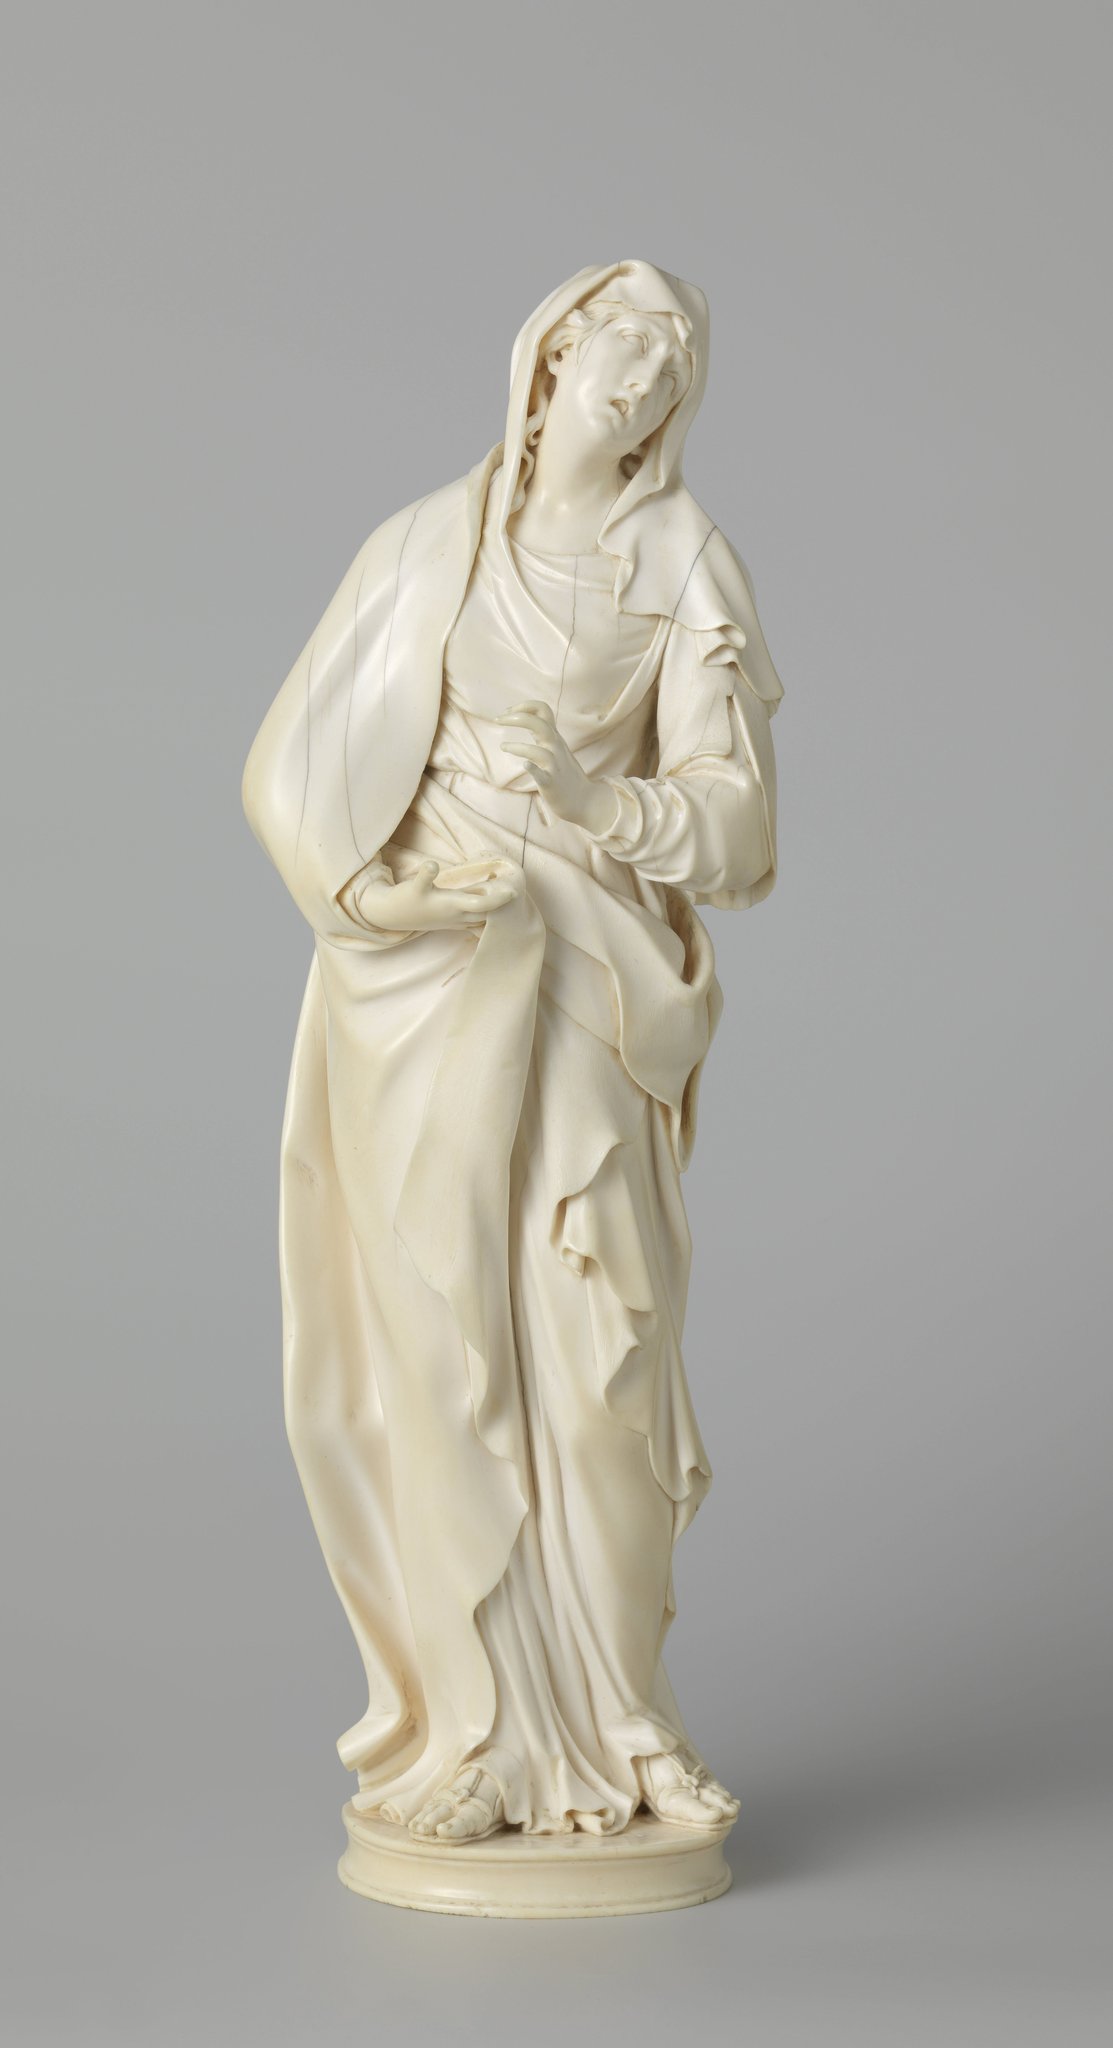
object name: figure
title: The Virgin and St John the Evangelist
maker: mattheus van beveren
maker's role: ivory carver, sculptor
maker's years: 1630-1690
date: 1670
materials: ivory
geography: brussels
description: The figures of the Virgin and the Apostle John originally flanked a crucified Christ. The Virgin is represented with an expression of intense sorrow, while he gazes upwards in dismay. Her masterfully carved, flowing robes and her face were inspired by the Italian Baroque. John’s dynamic pose is derived from a famous sculptural group from Classical antiquity, the Laocoön.